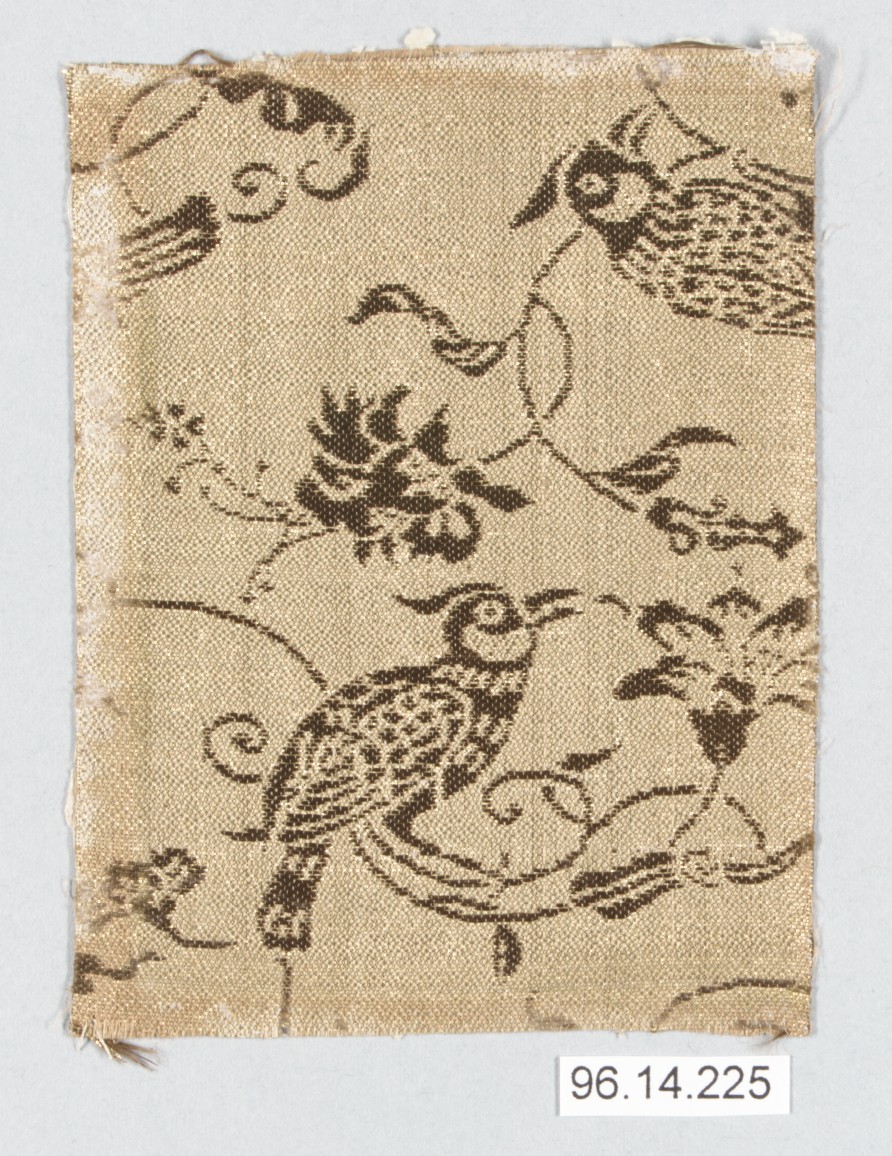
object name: piece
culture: japanese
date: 1701-1900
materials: silk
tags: flowers